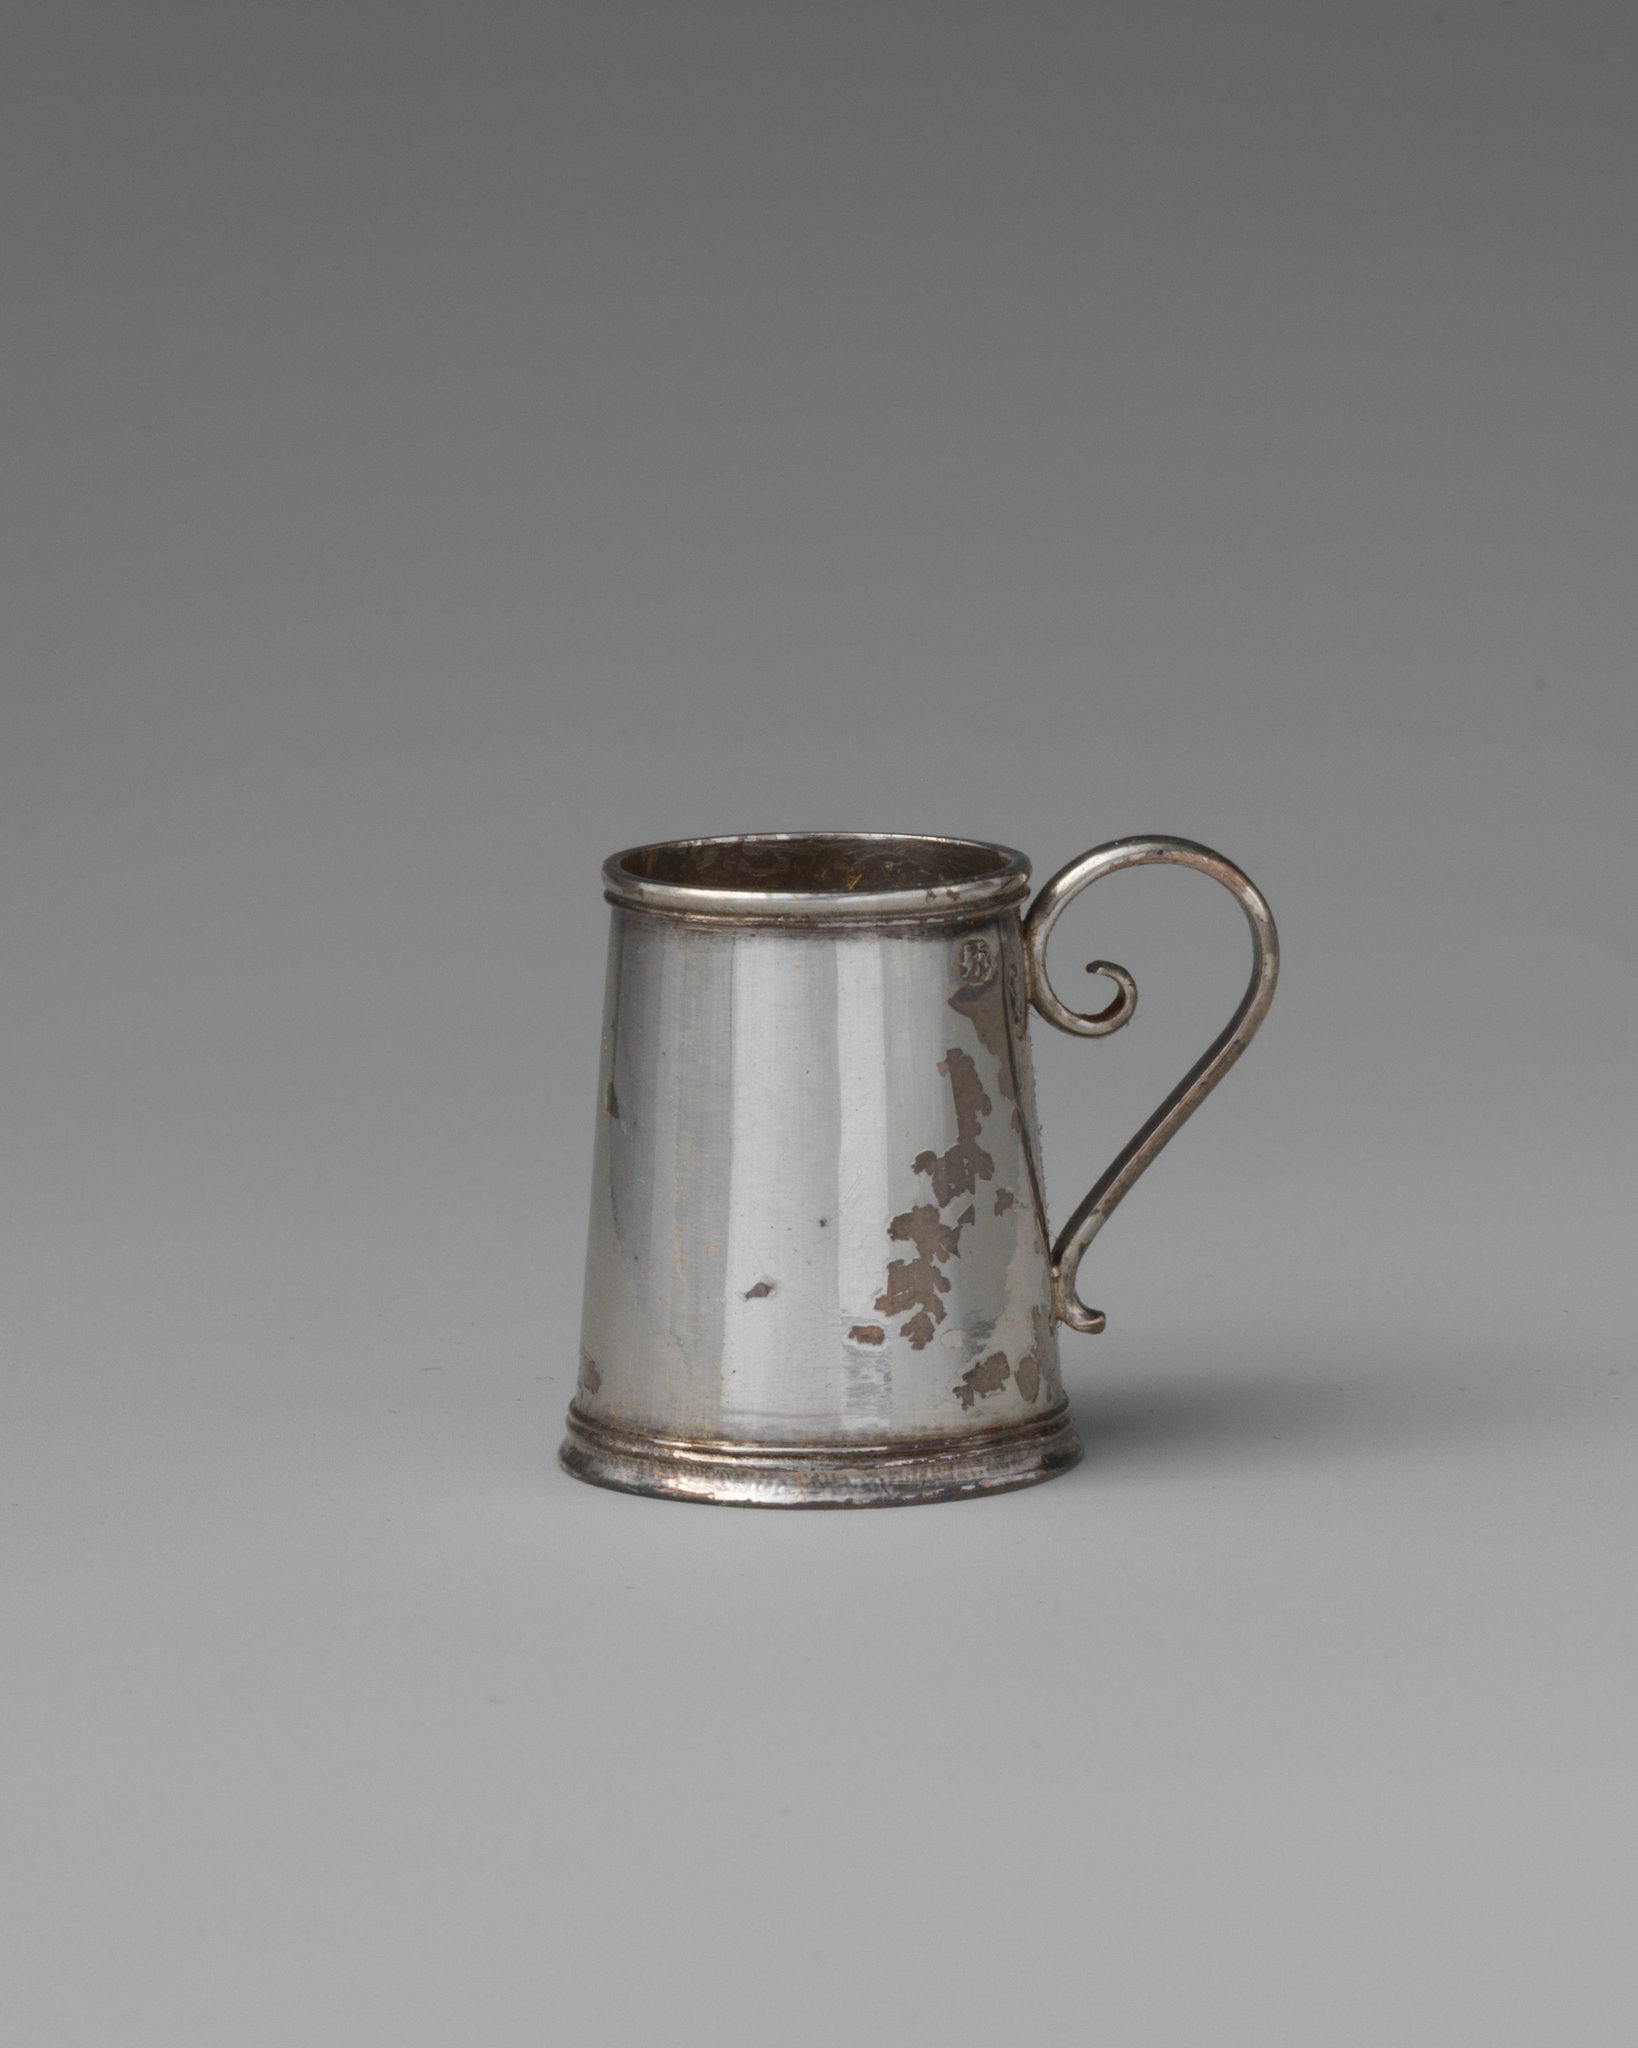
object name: mug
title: Miniature mug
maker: david clayton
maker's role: artist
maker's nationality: british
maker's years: 1659-1719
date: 1720-1730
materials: silver